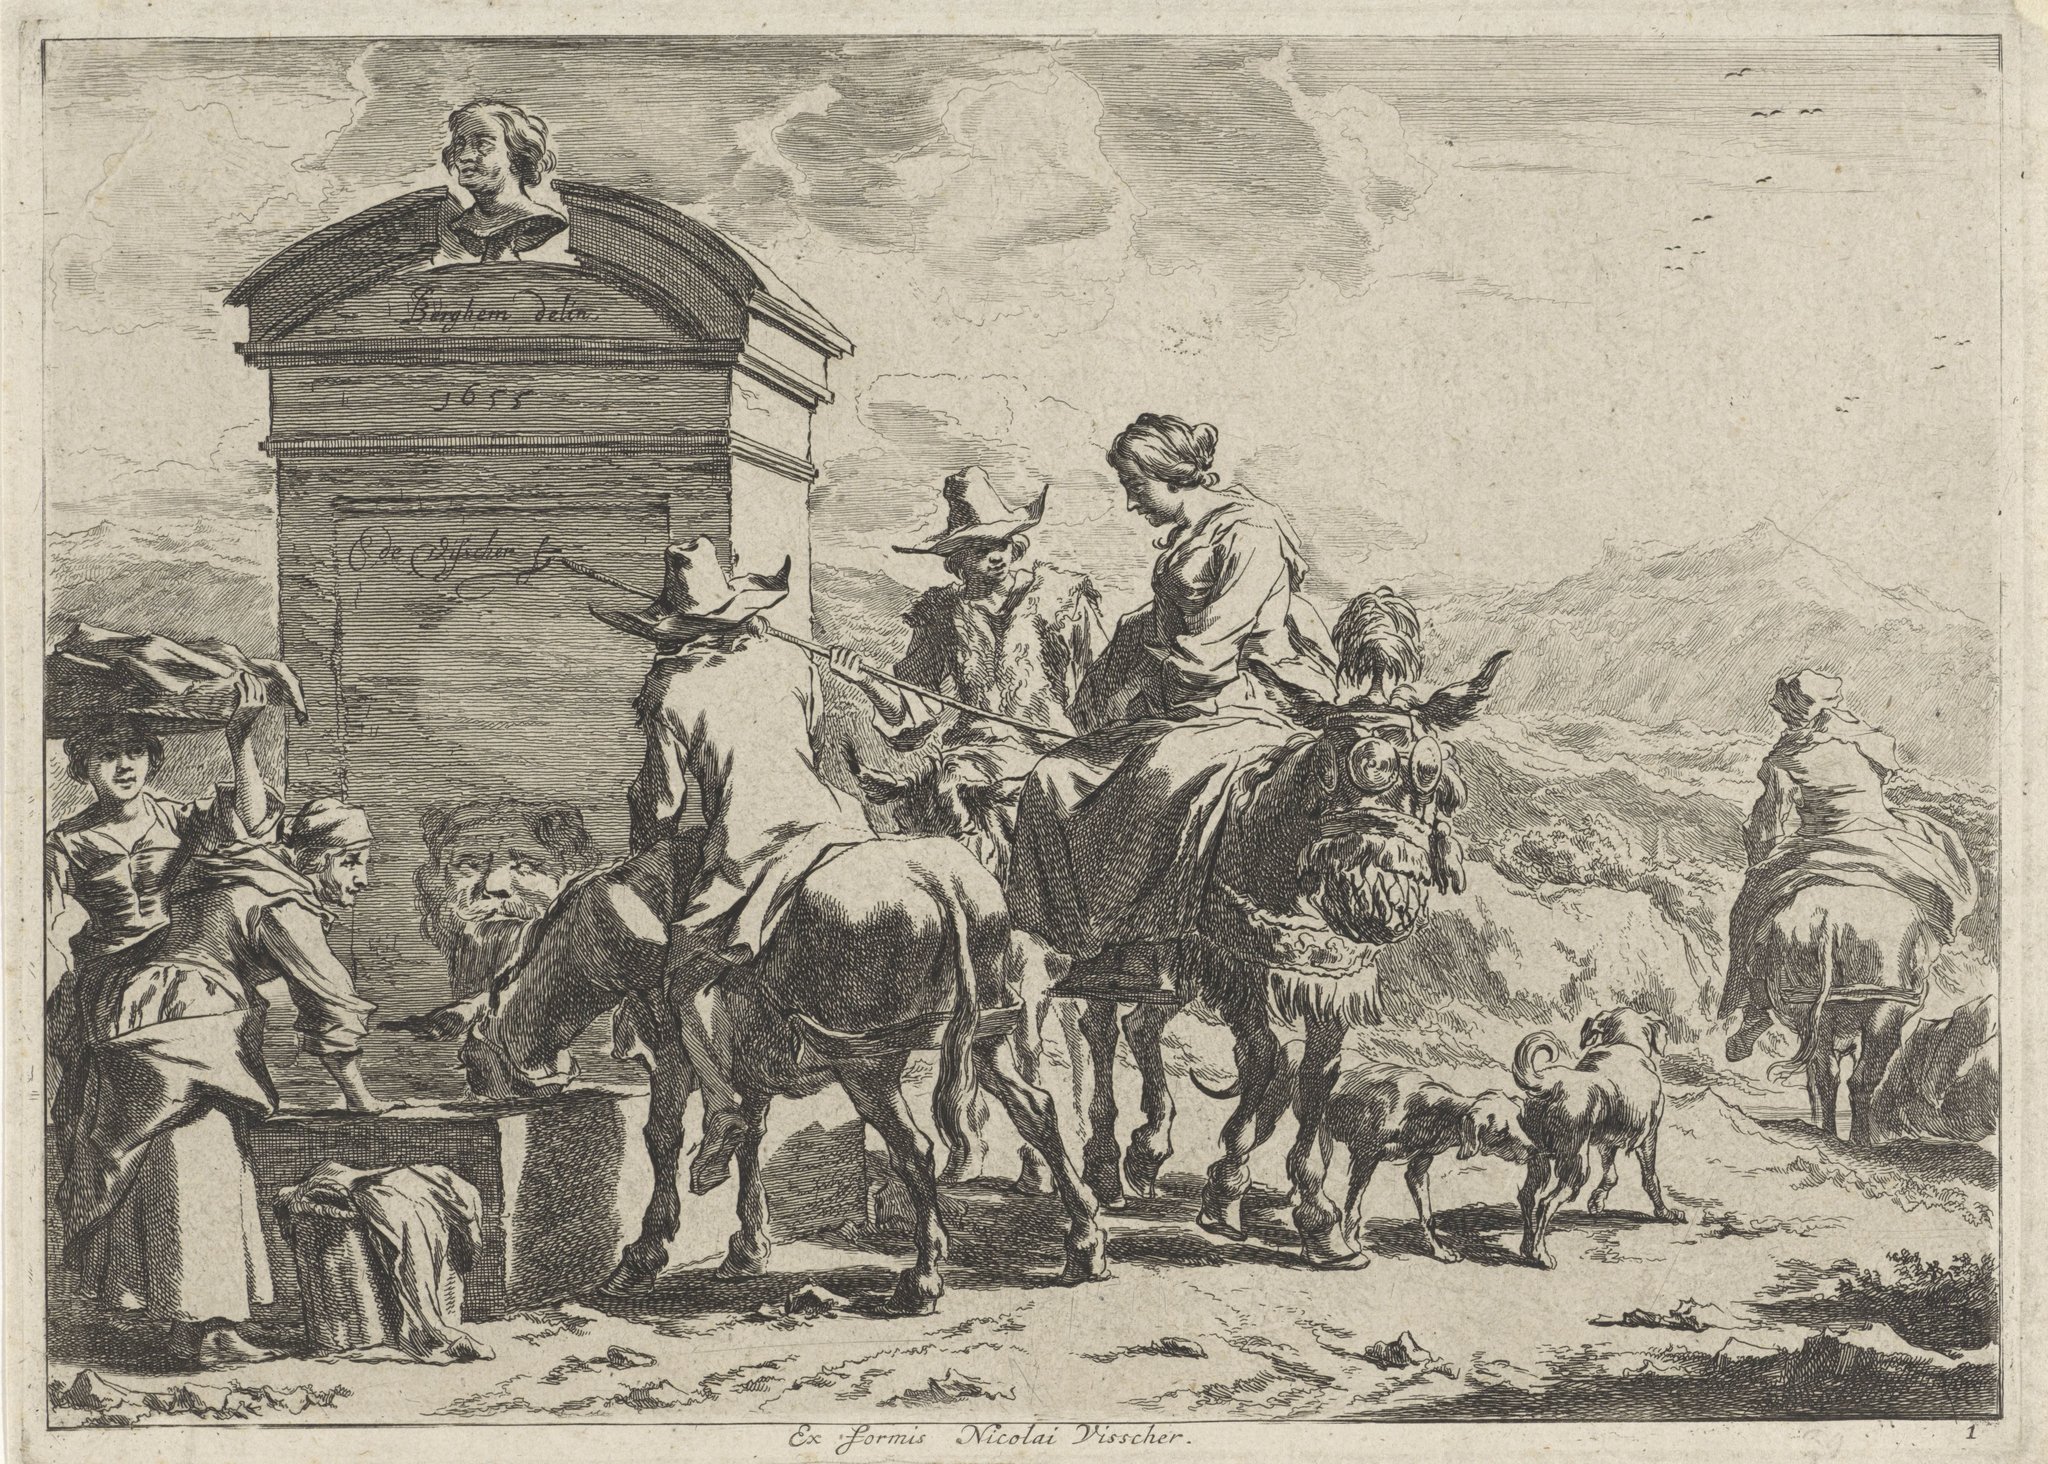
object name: print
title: Landschappen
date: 1655-1709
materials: paper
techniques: engraving, etching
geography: amsterdam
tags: landscapes, ornamental fountain, stadia of travel, dog, donkey-riding (on the beach)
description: In een heuvelachtig landschap pauzeert een groep reizigers, waarvan er drie op een ezel zitten, bij een fontein. Bij de fontein staan ook twee wasvrouwen. Rechts besnuffelt een hond een andere hond.